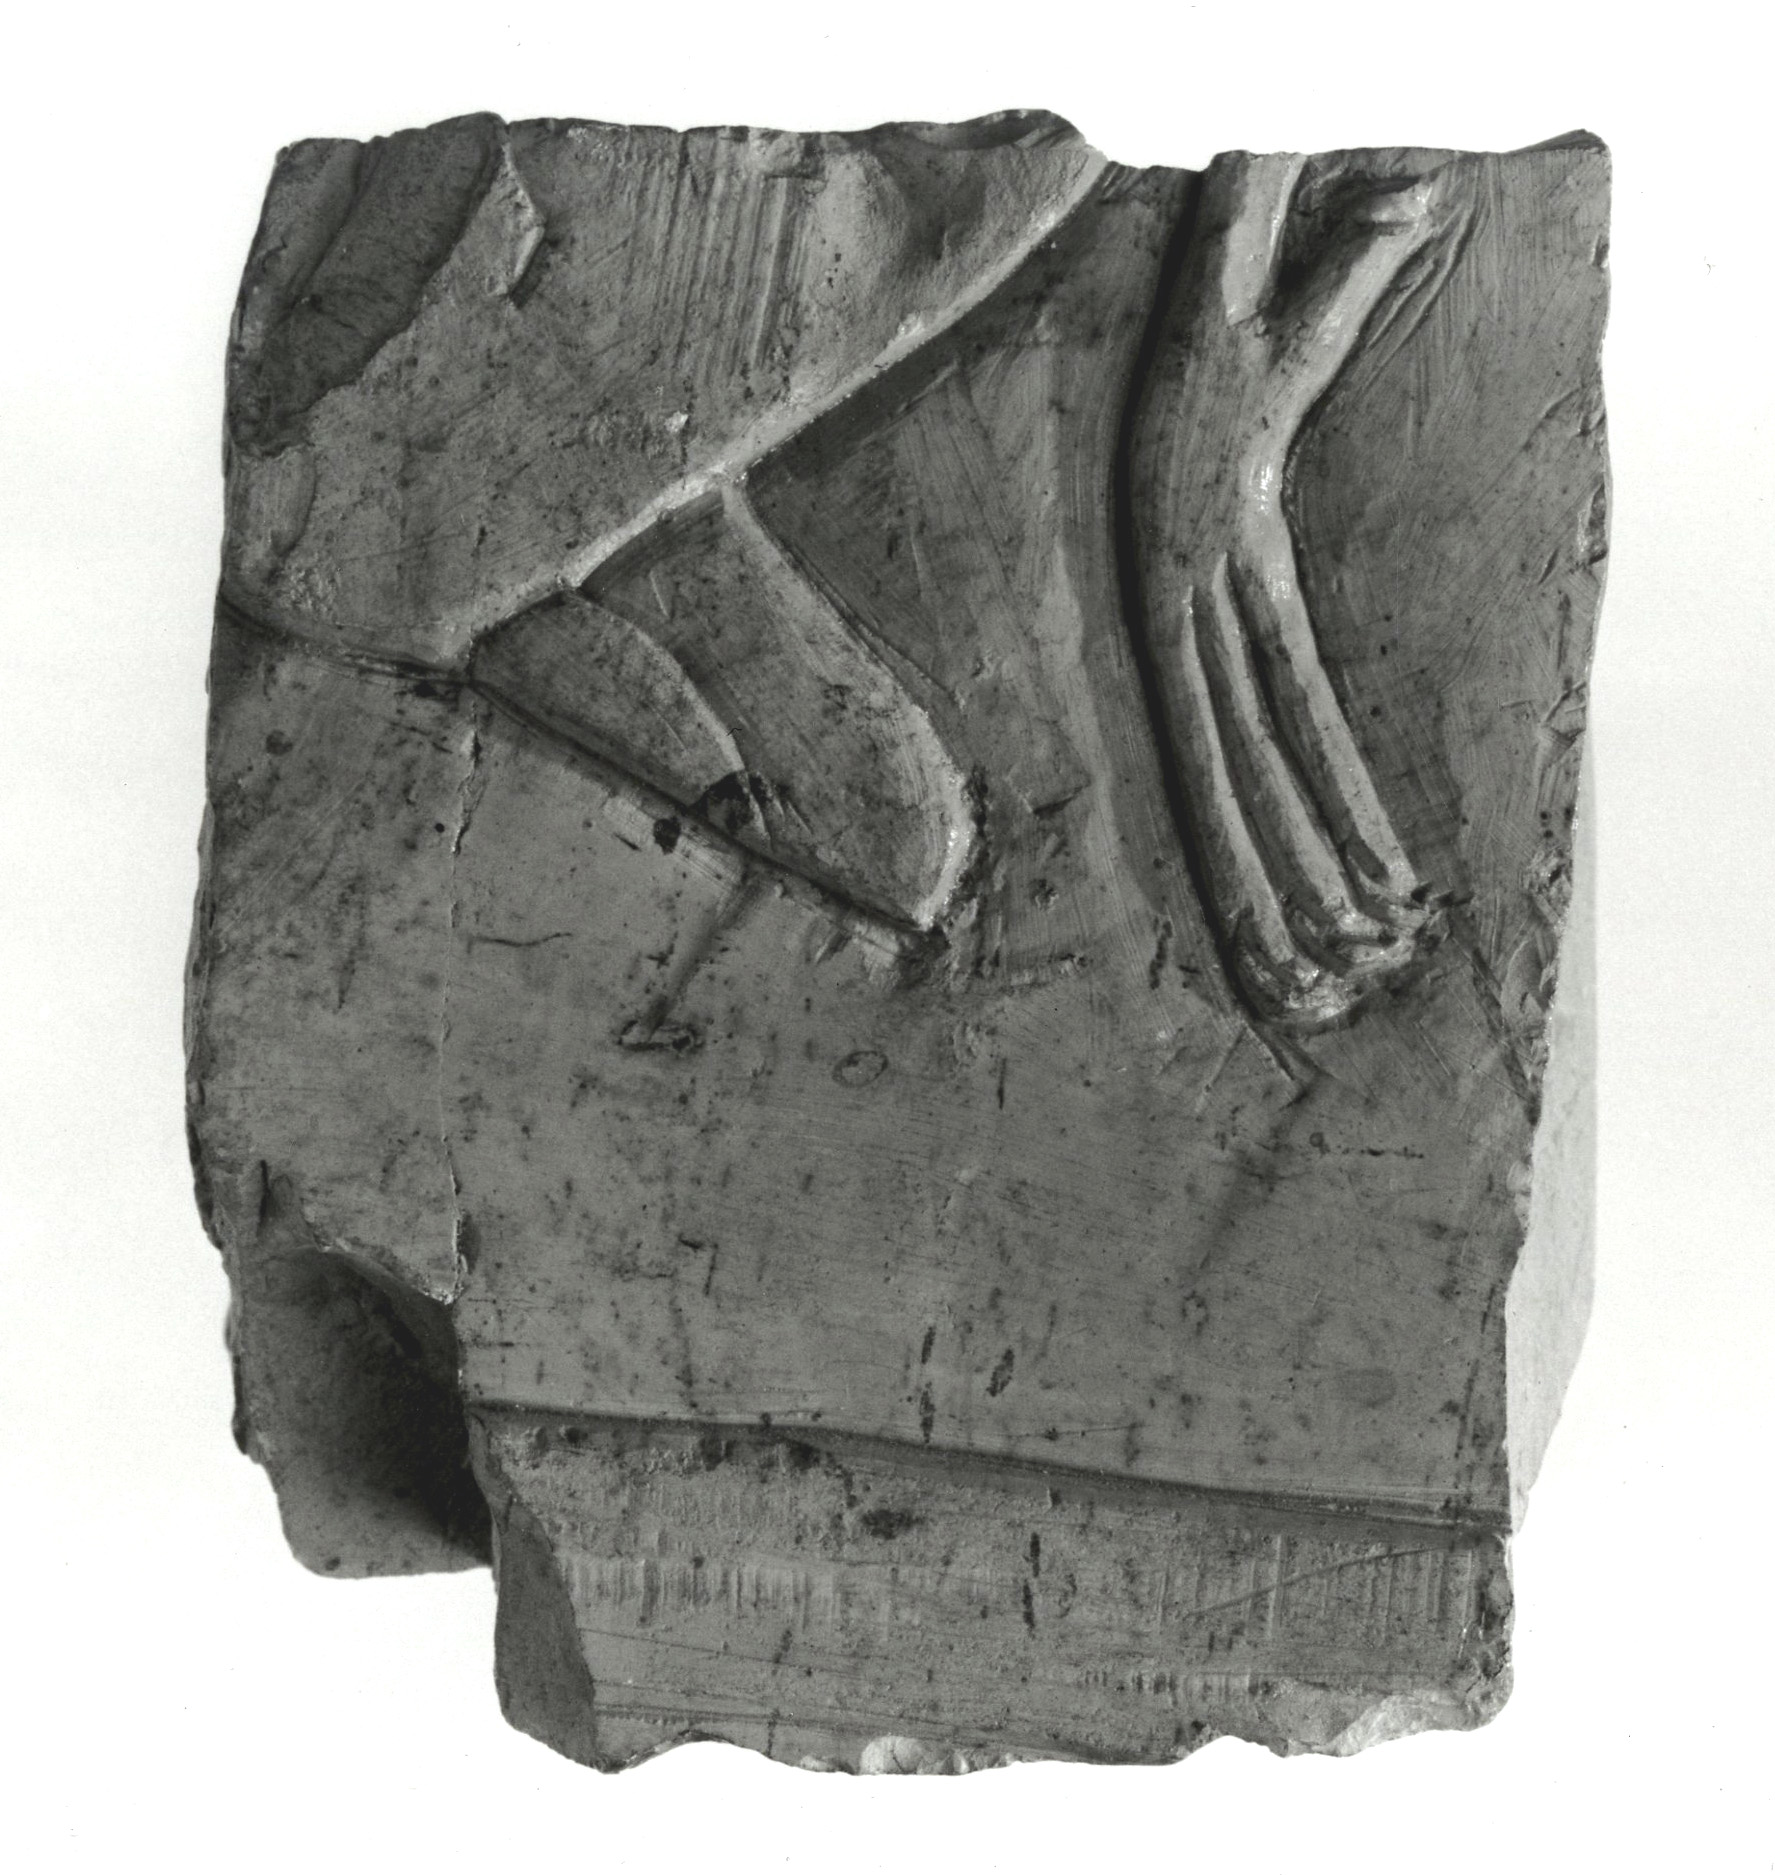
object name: relief, tomb of nespekashuty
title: Raised relief fragment with a hieroglyph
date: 664-610 BCE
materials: limestone, varnish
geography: egypt